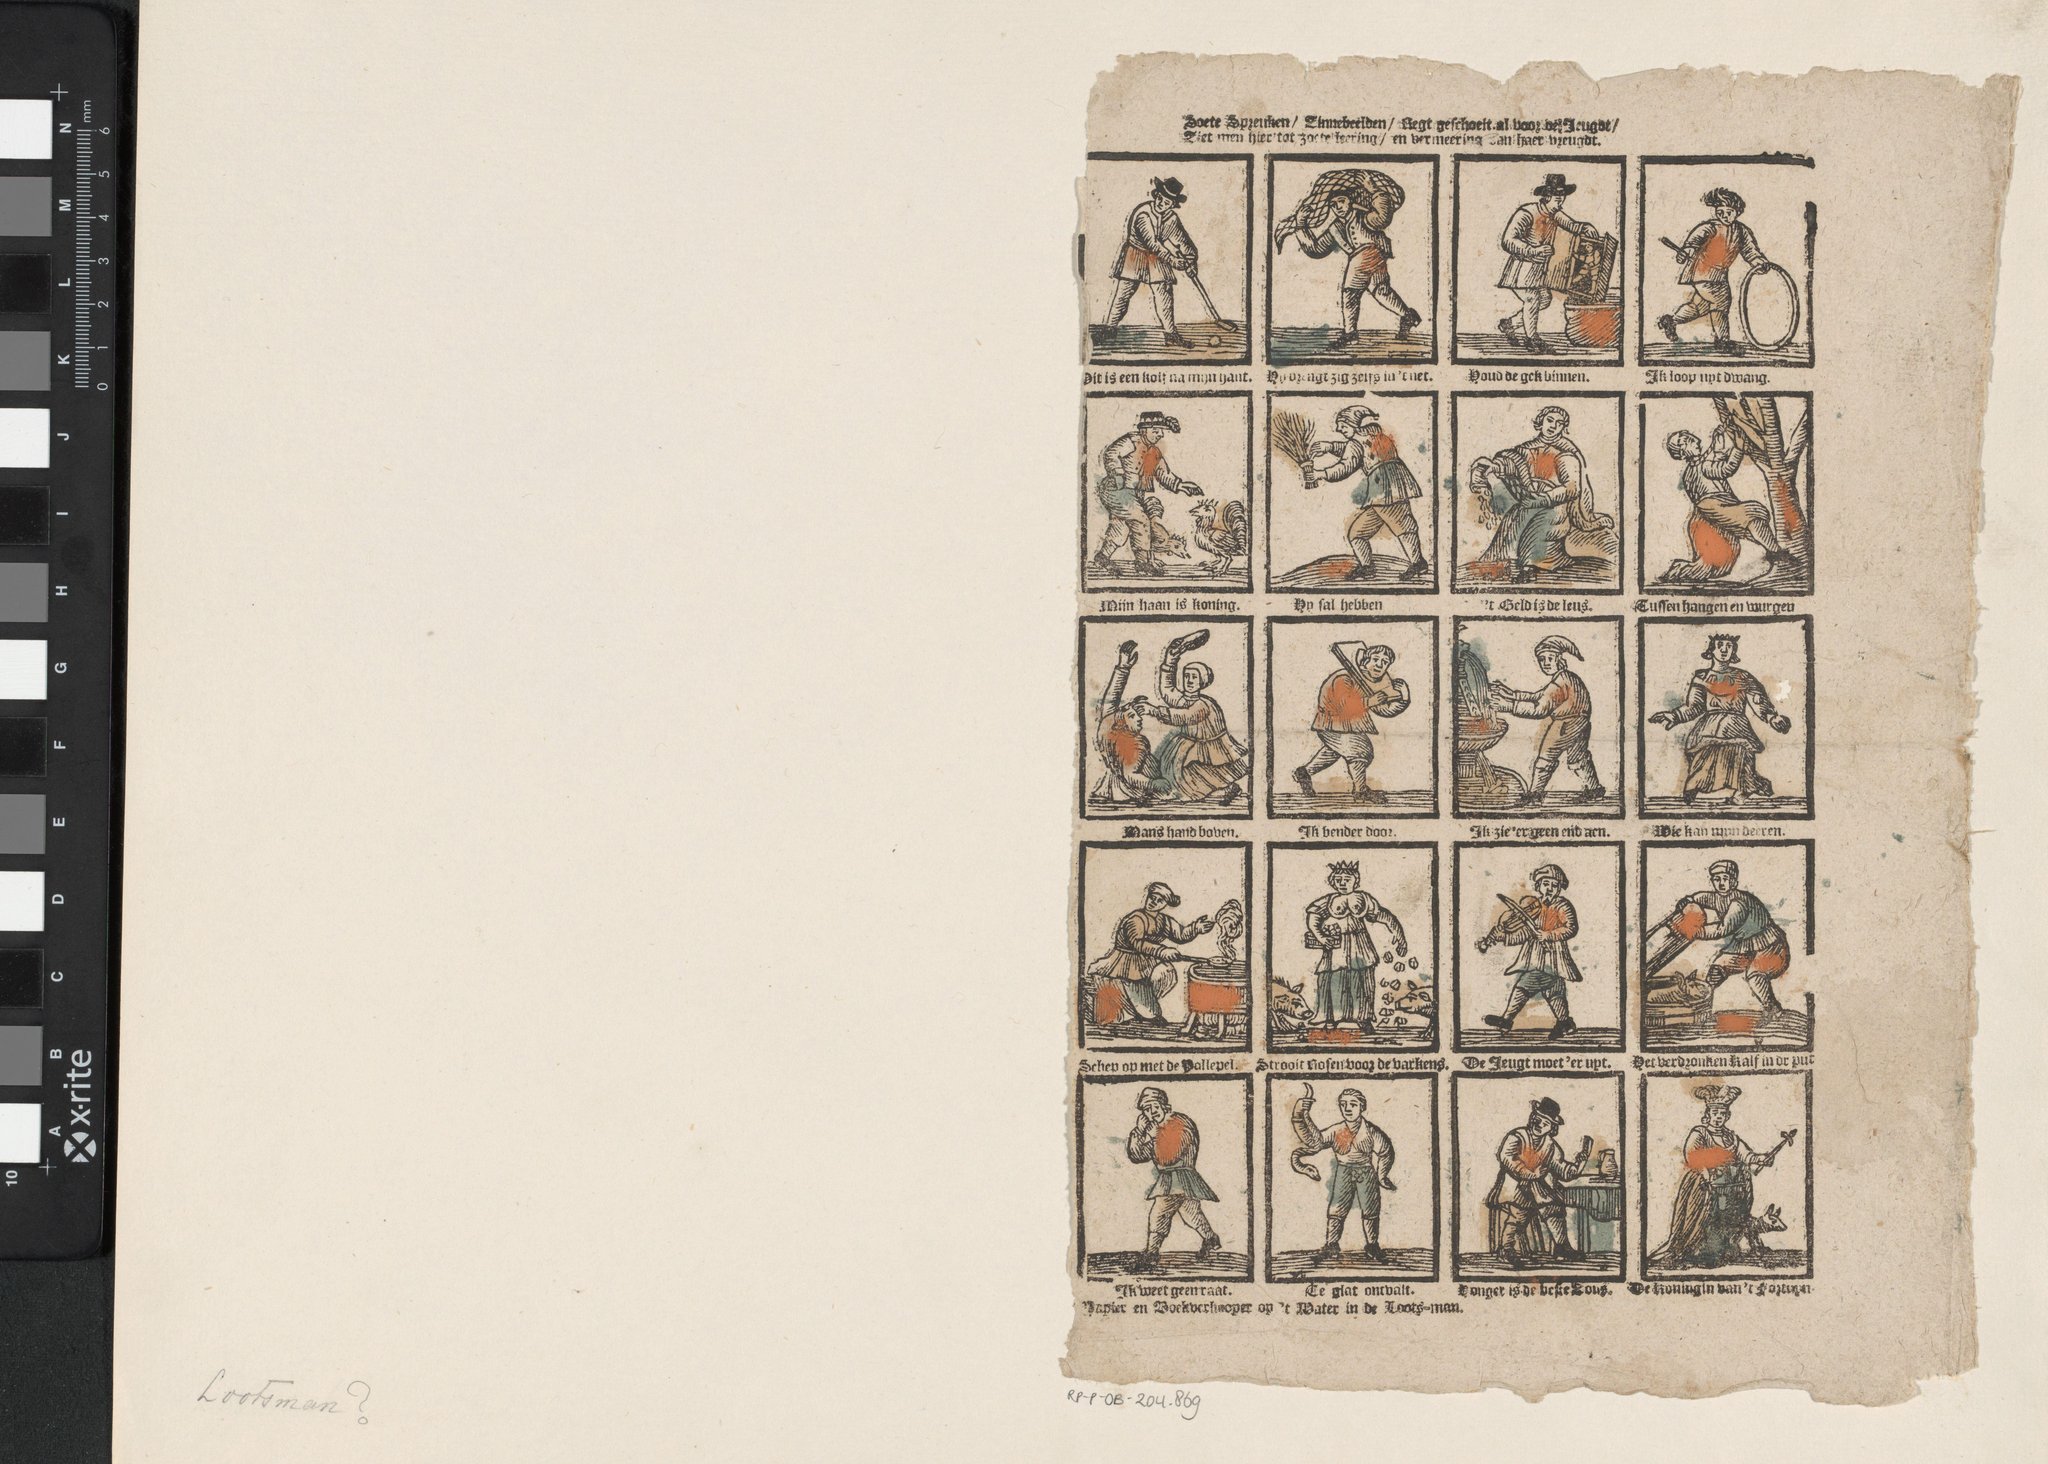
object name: print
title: [(...)] / Soete spreuken / Zinnebeelden / slegt geschoeit al voor de jeugdt / Ziet men hier tot z[(...)]sering / en vermeering van haer vreugdt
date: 1622-1711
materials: paper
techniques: colour, letterpress printing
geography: netherlands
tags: musician at work, children's games and plays, human types, farmers, games using special objects (marbles, top, hoop, etc.)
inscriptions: collector's mark: Lugt 2760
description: Blad met 20 (deel afgescheurd) voorstellingen van verschillende figuren en bezigheden. Onder elke afbeelding een onderschrift.